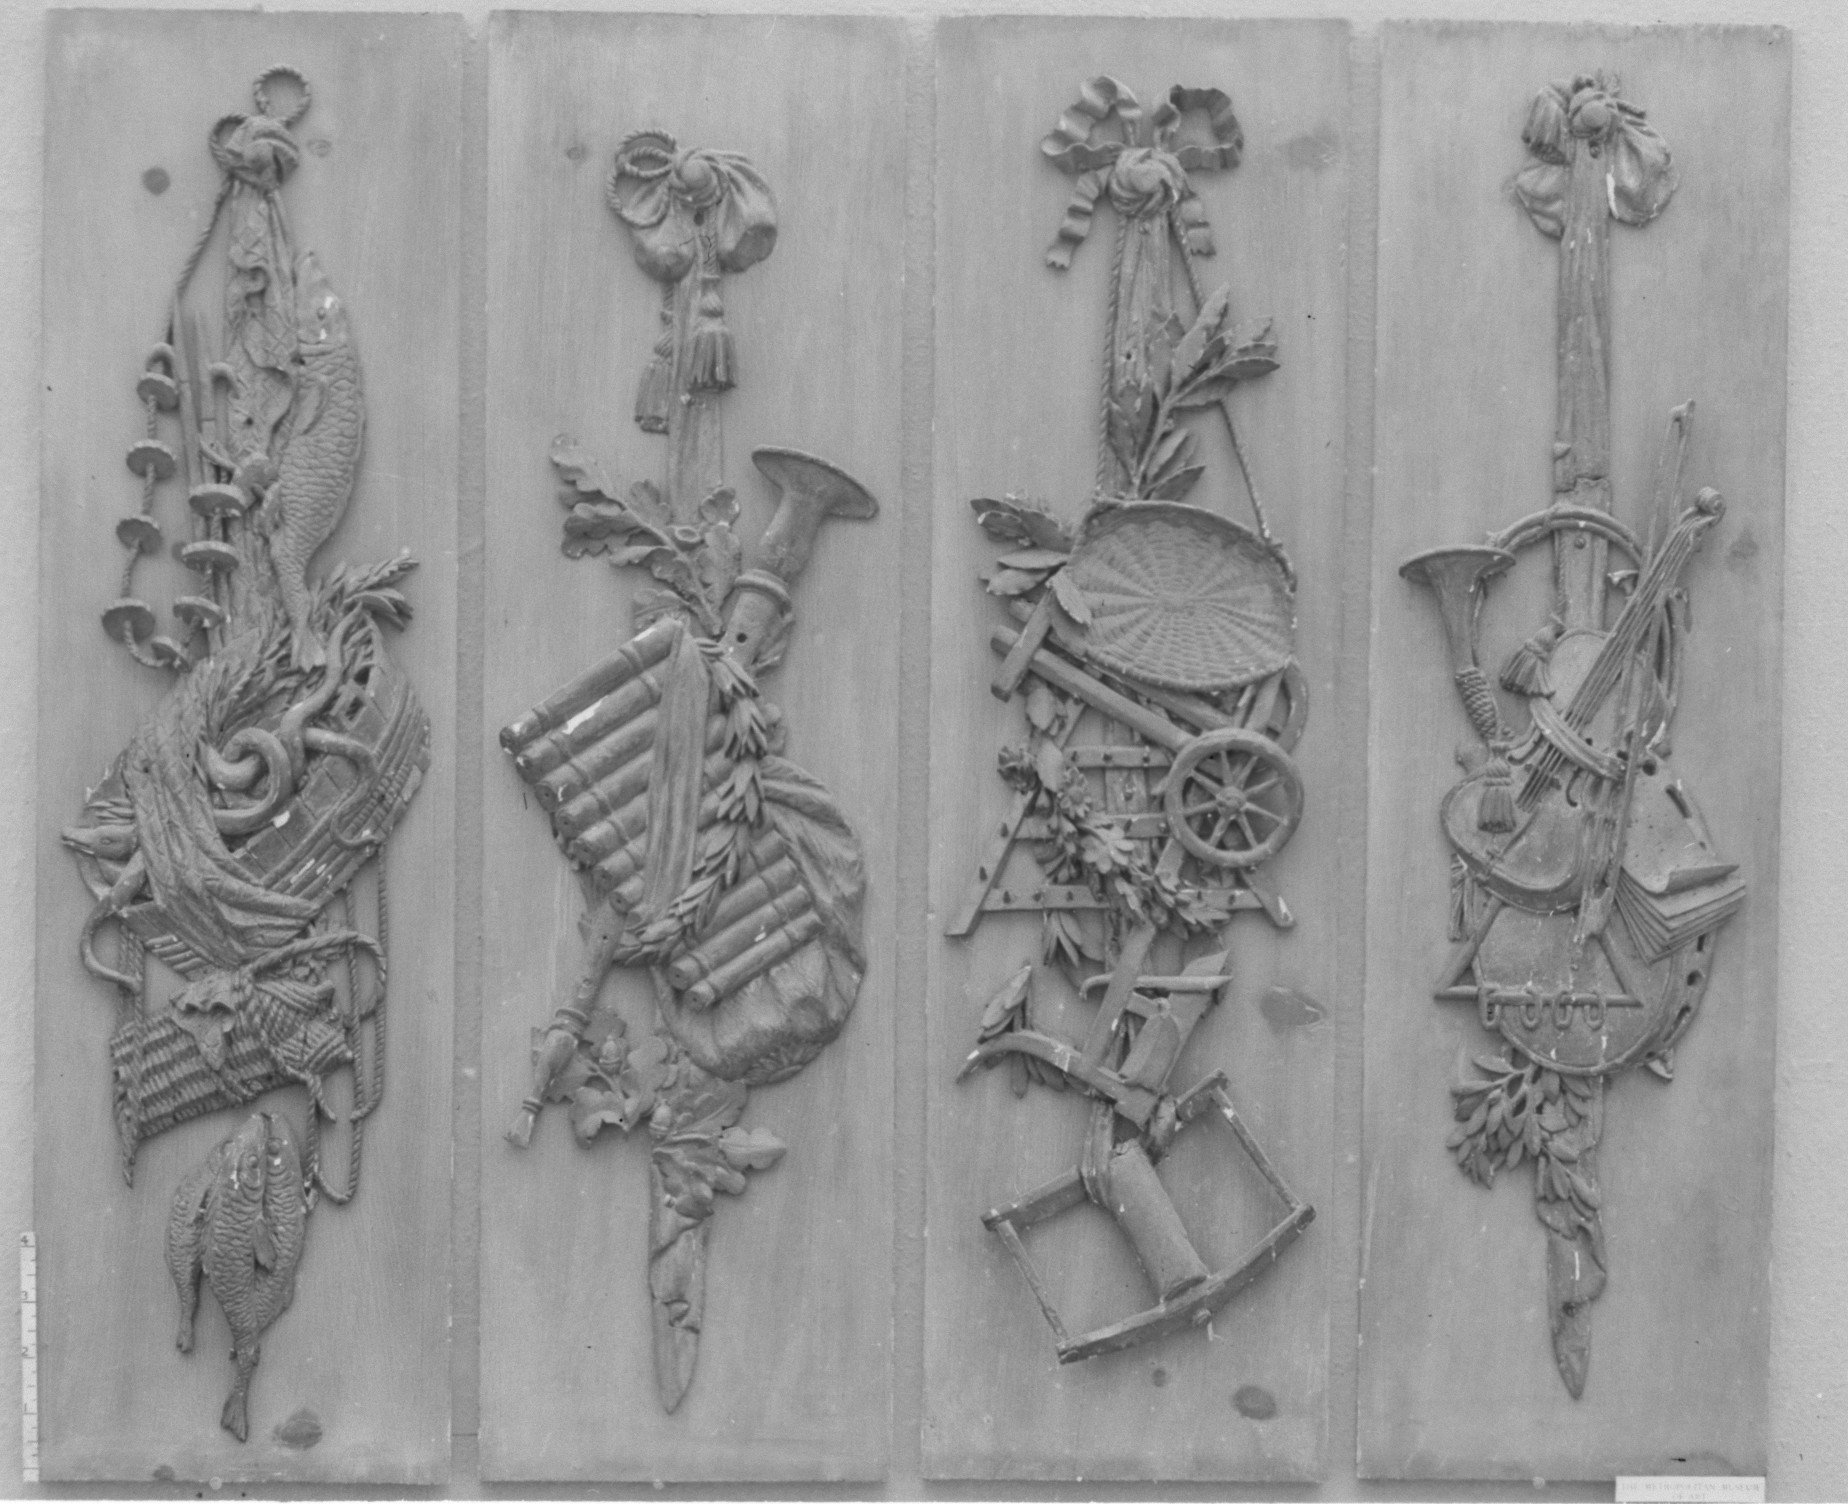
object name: panel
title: Panel (part of a set)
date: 1701-1800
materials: wood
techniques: gilding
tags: musical instruments,fish